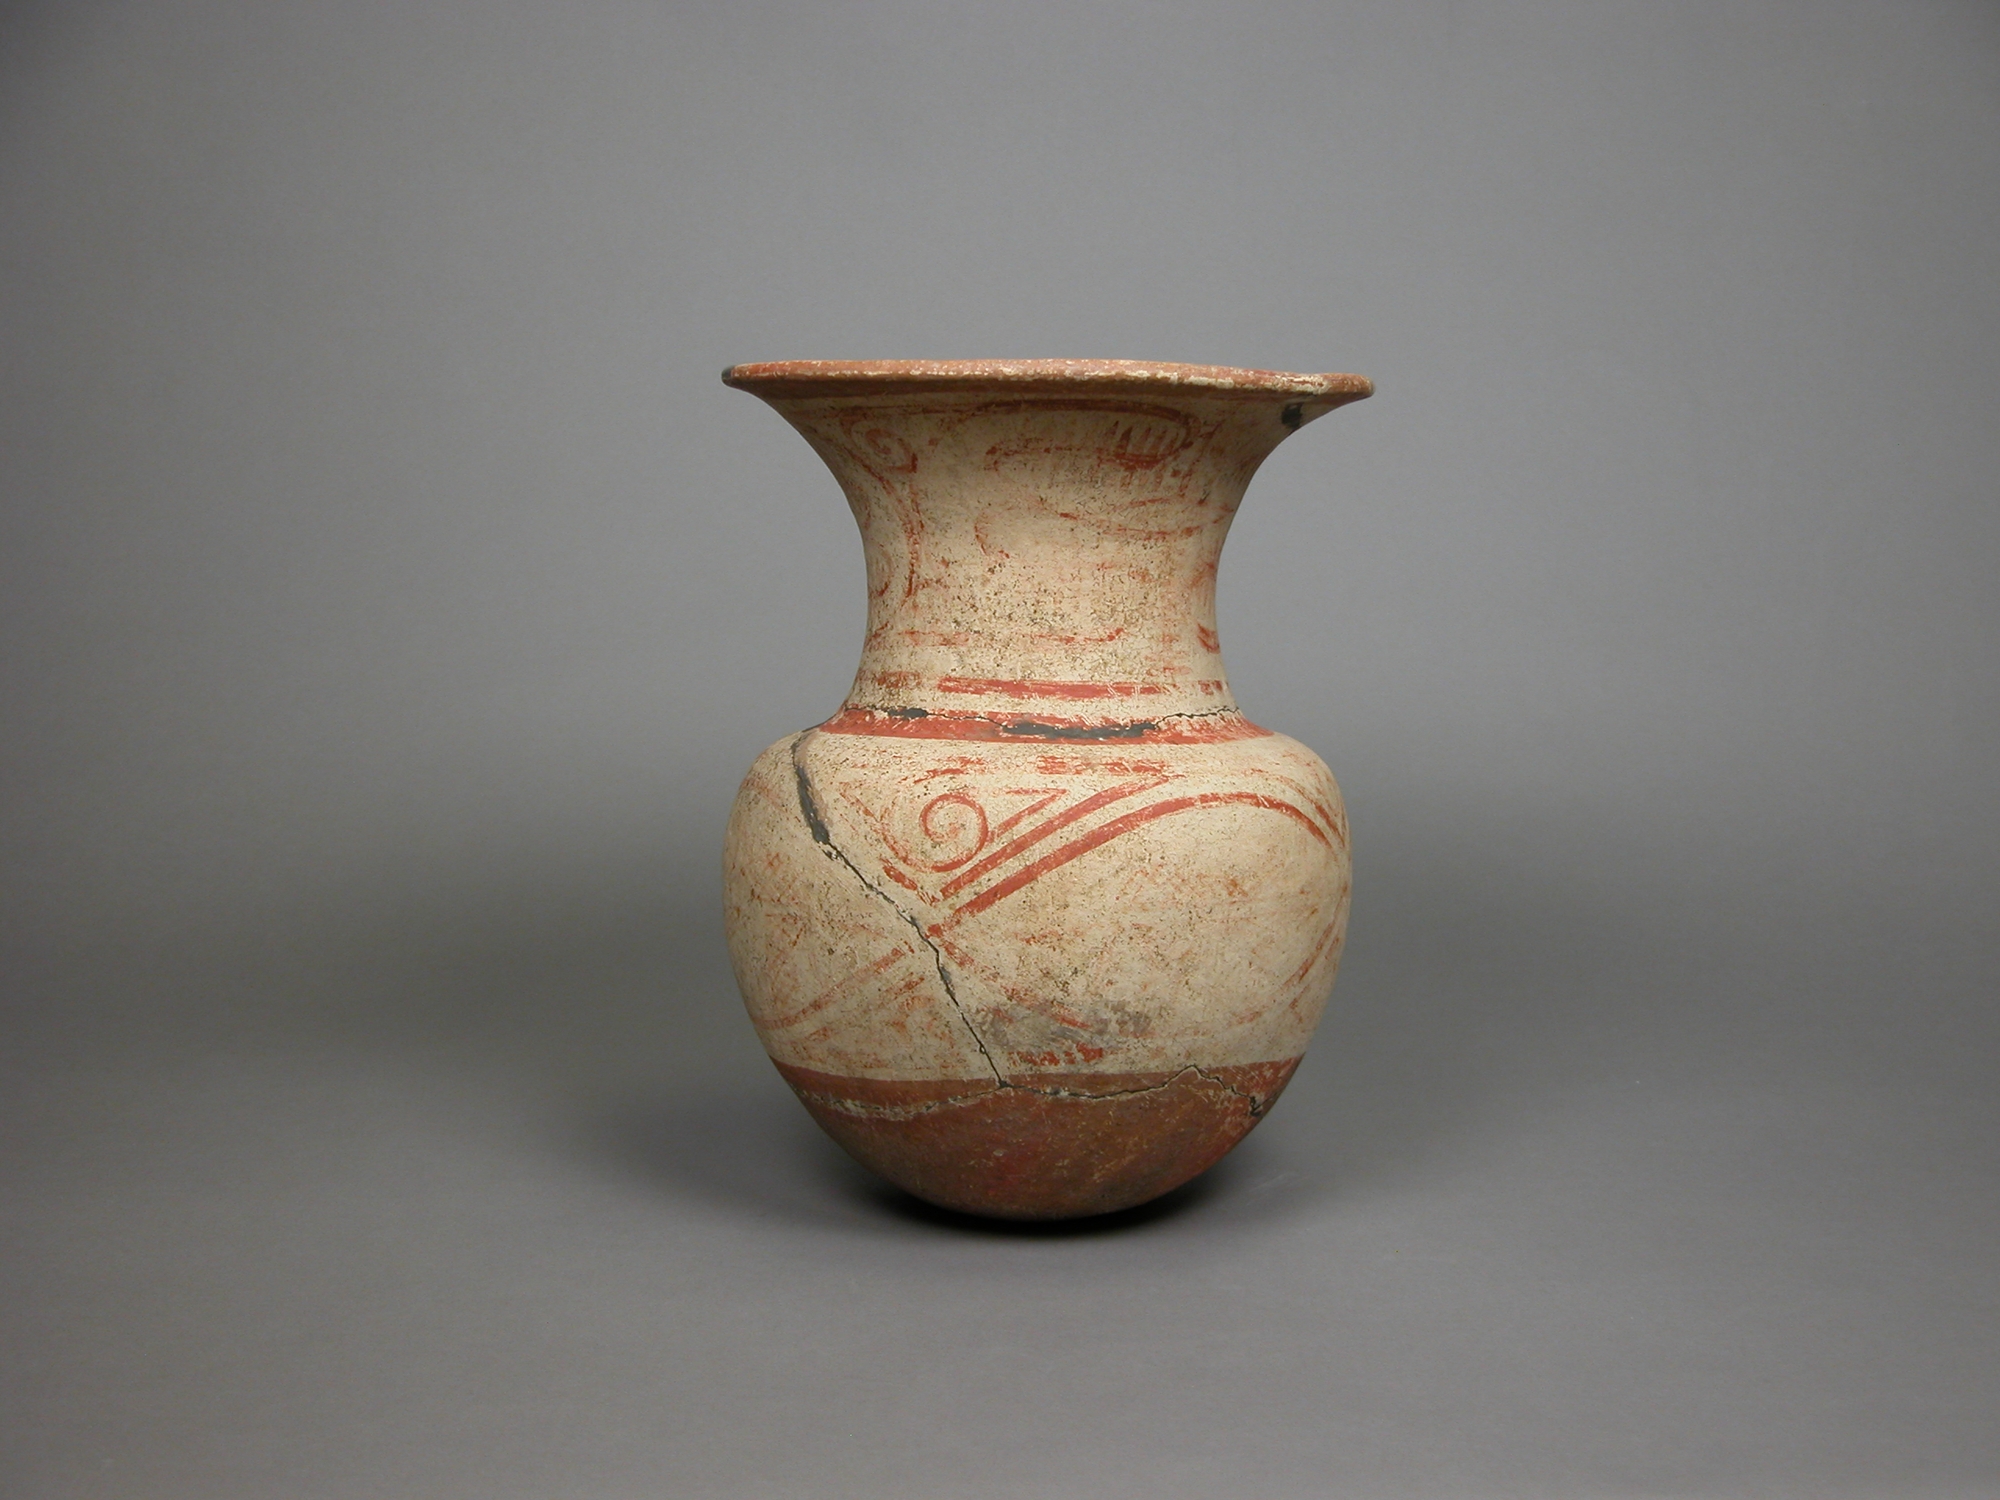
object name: vessel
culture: thai, ban chiang culture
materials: terracotta